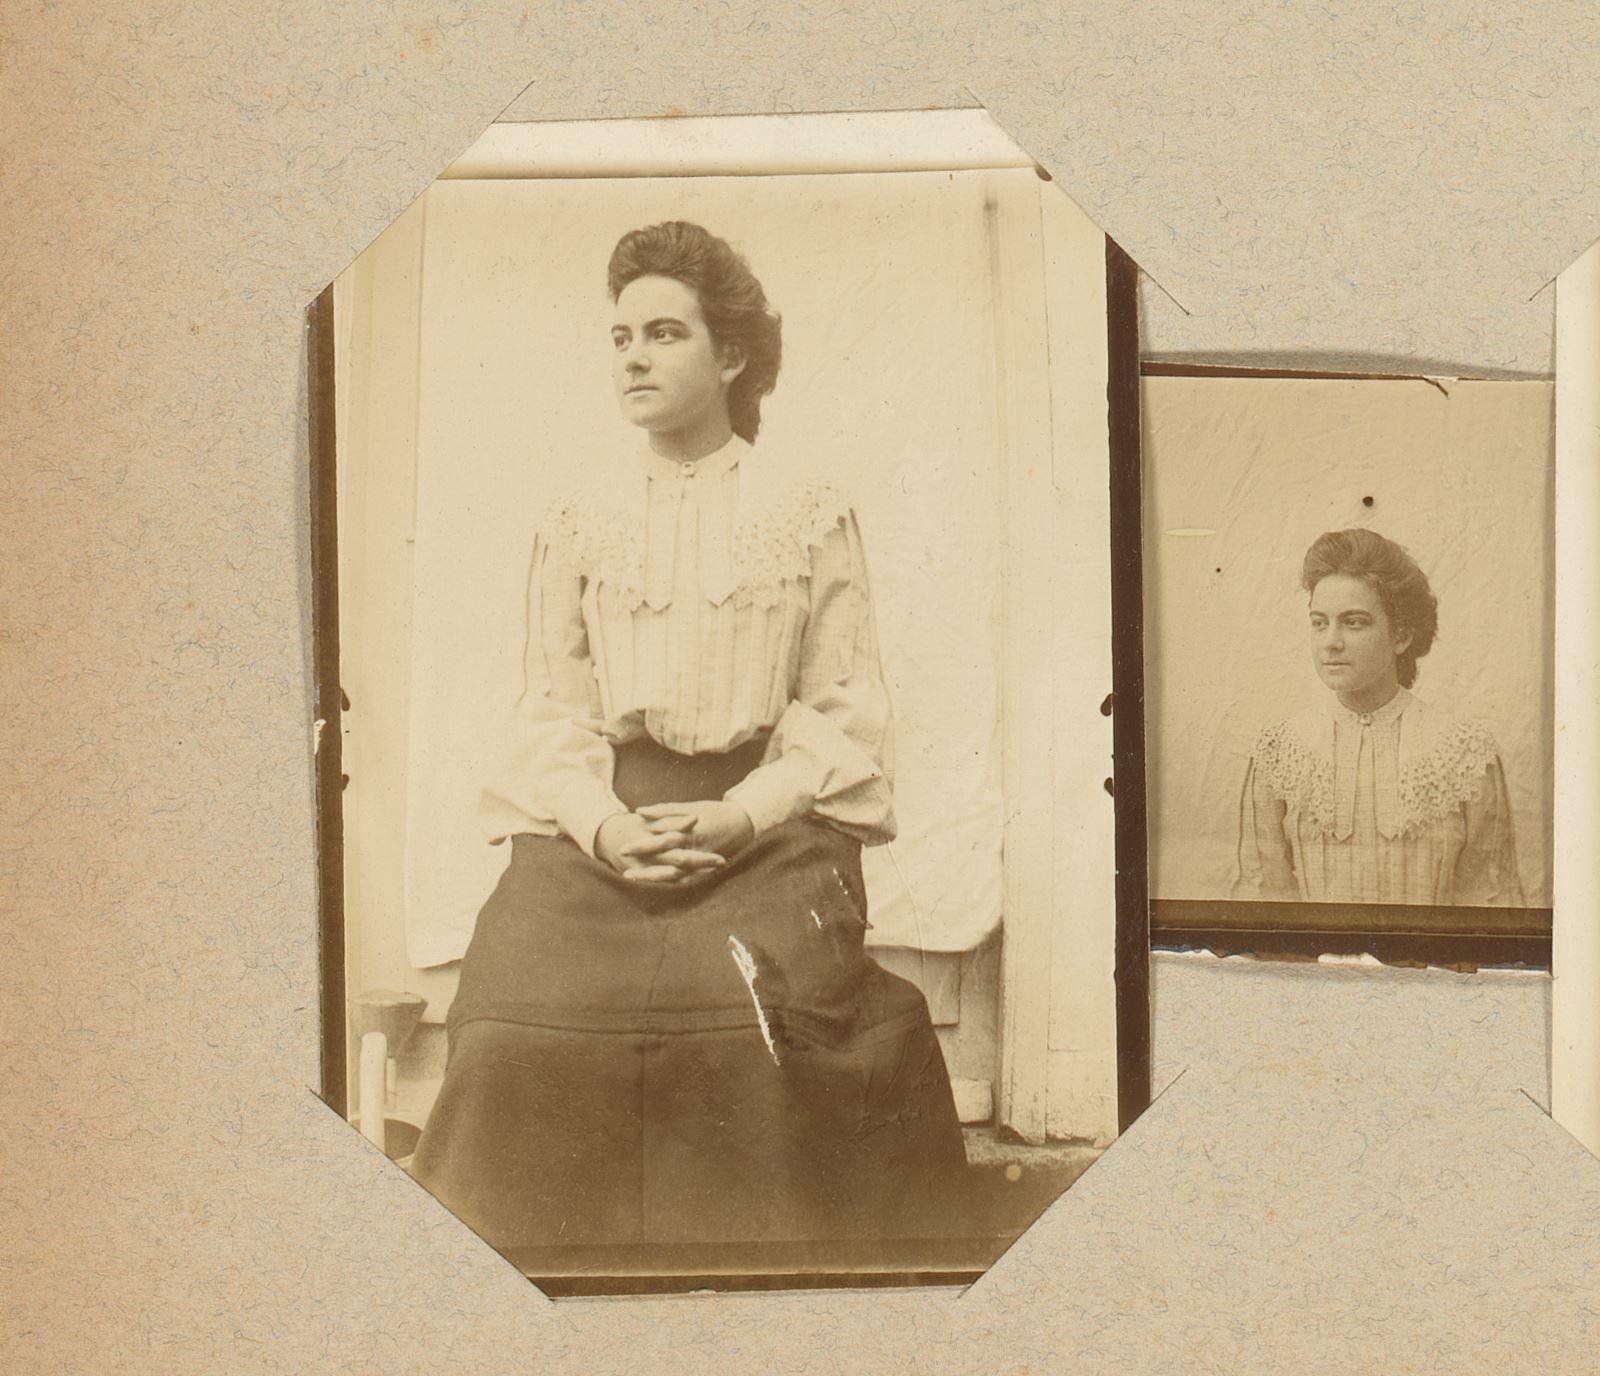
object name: album leaf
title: Portret van een jonge vrouw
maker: Anonymous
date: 1897-1900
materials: paper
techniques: gelatin silver print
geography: france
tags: adolescent, young woman, maiden, historical persons, france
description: Over de foto is een ander negatief afgedrukt van een voorstelling van bomen.